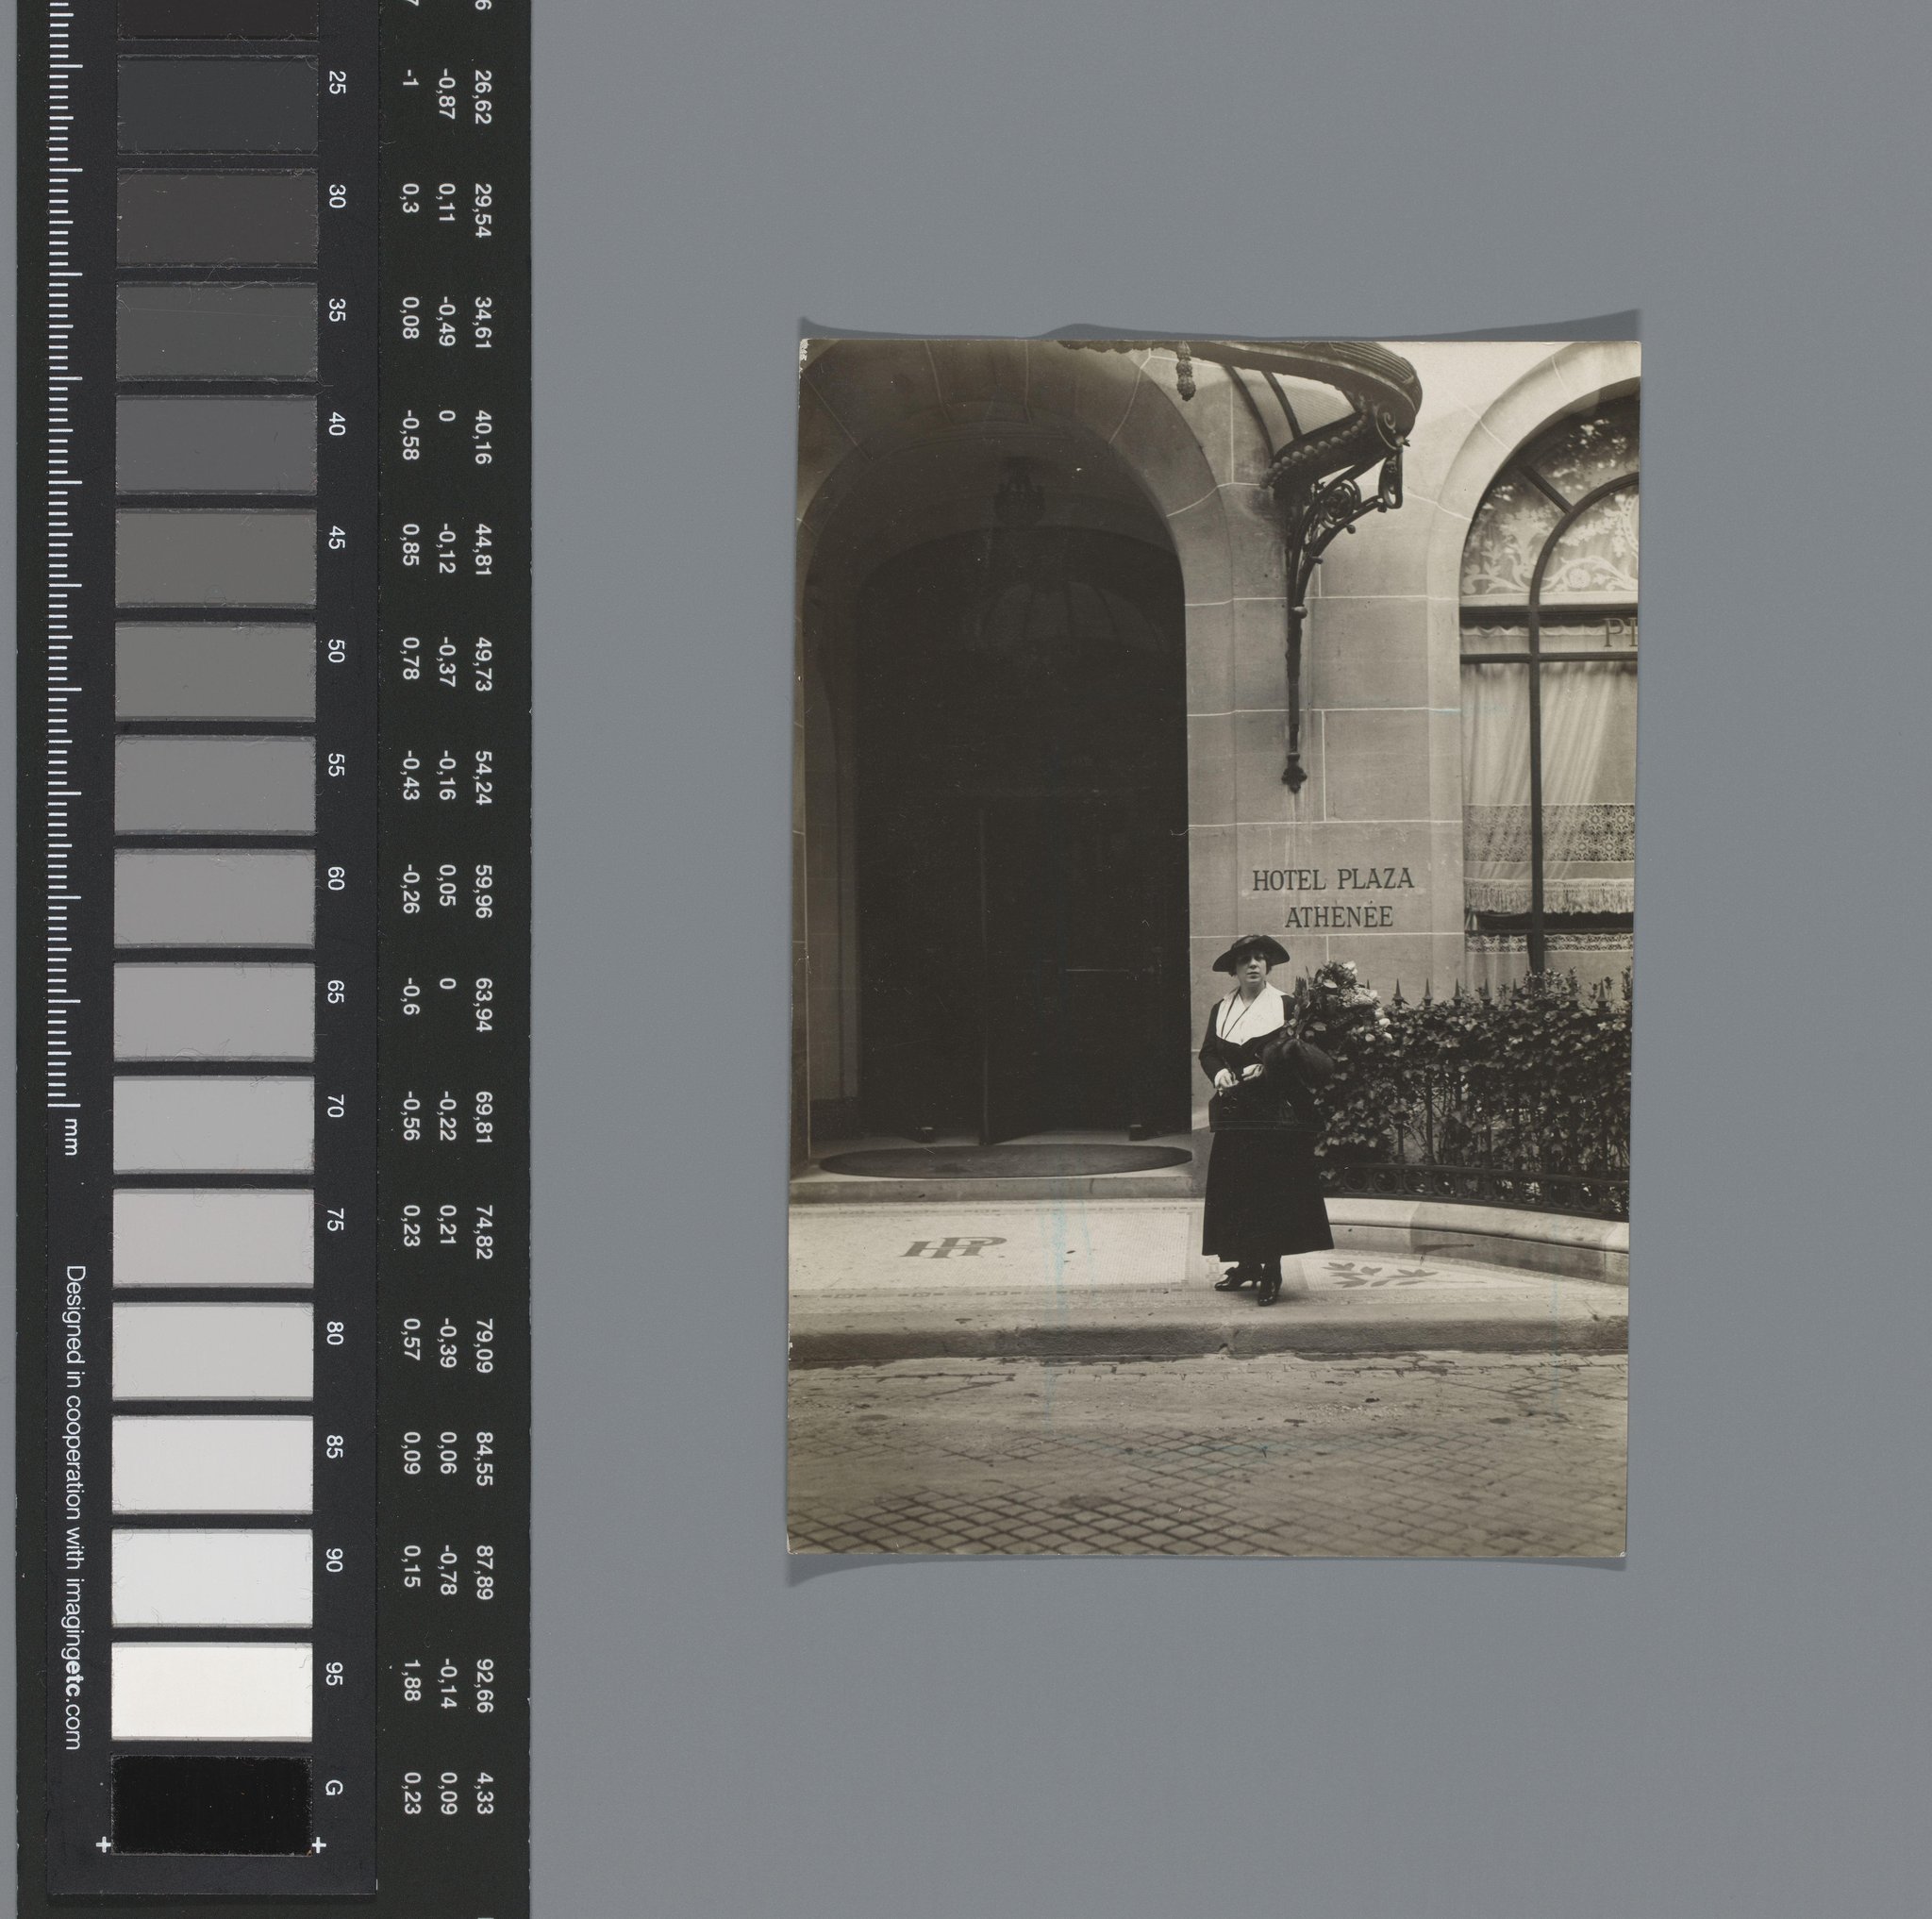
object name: photograph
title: Vrouw op straat met een boeket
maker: Anonymous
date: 1916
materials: photographic support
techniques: gelatin silver print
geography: paris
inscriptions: inscription: ‘Àffaire Costa’